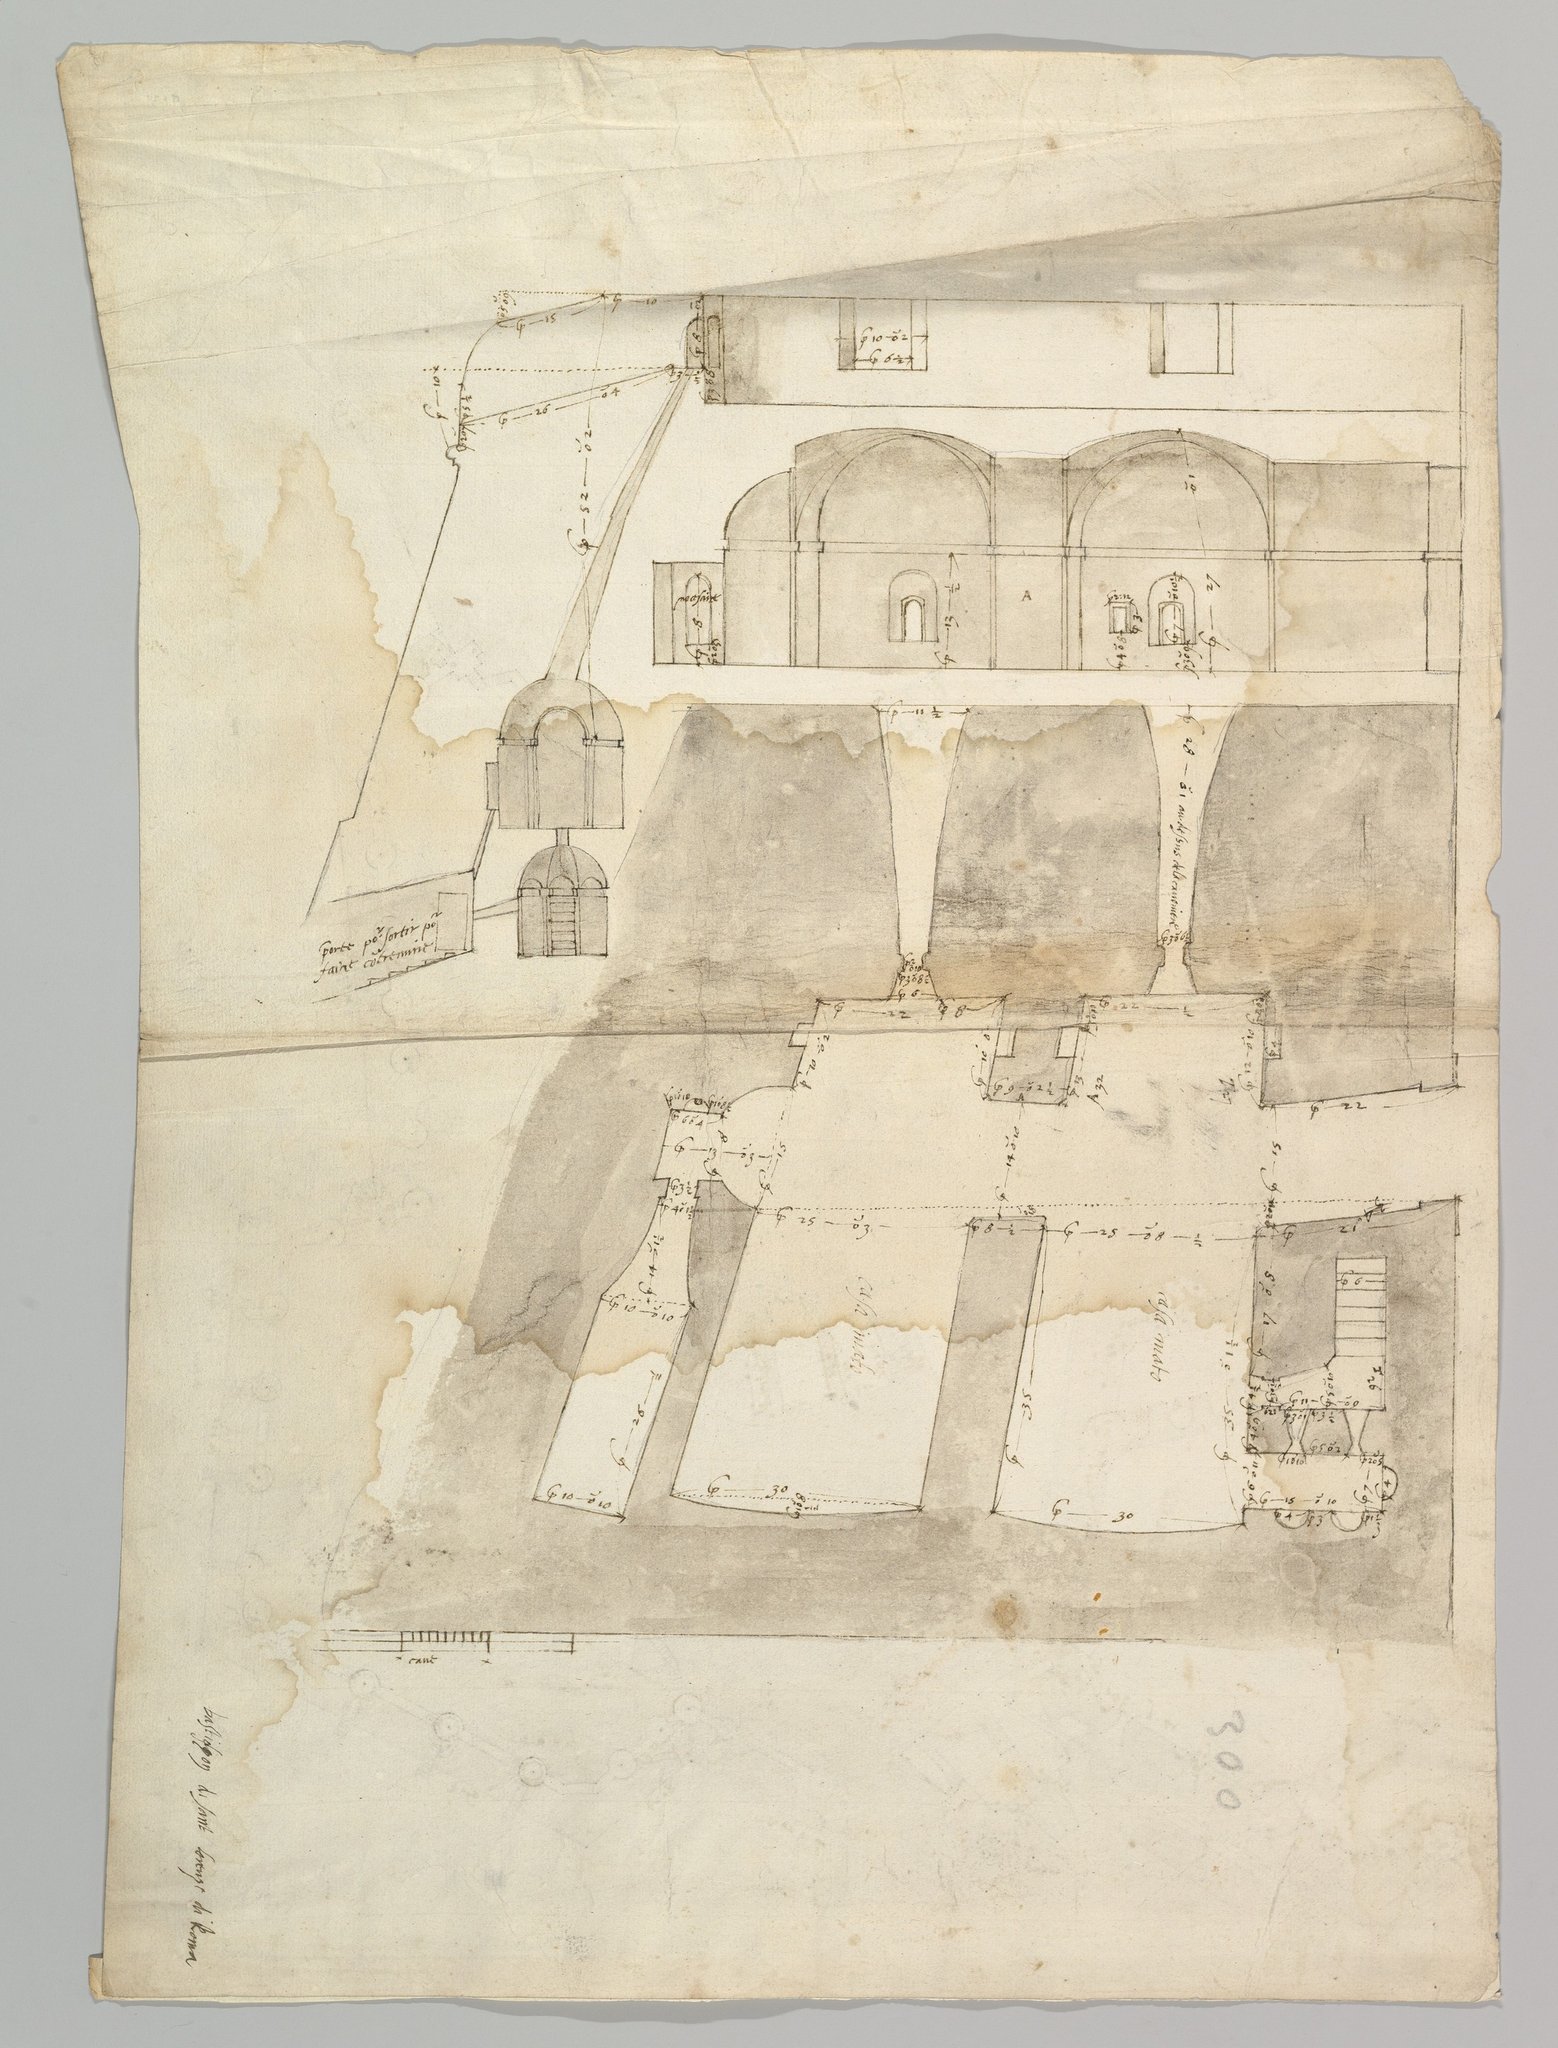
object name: drawing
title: Bastione Ardeatino, Rome, plan and section (recto) Bastione Ardeatino, Rome, plans (verso)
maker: anonymous, french, 16th century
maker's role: draftsman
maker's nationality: french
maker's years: 1500-1600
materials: chalk, ink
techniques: incising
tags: architecture